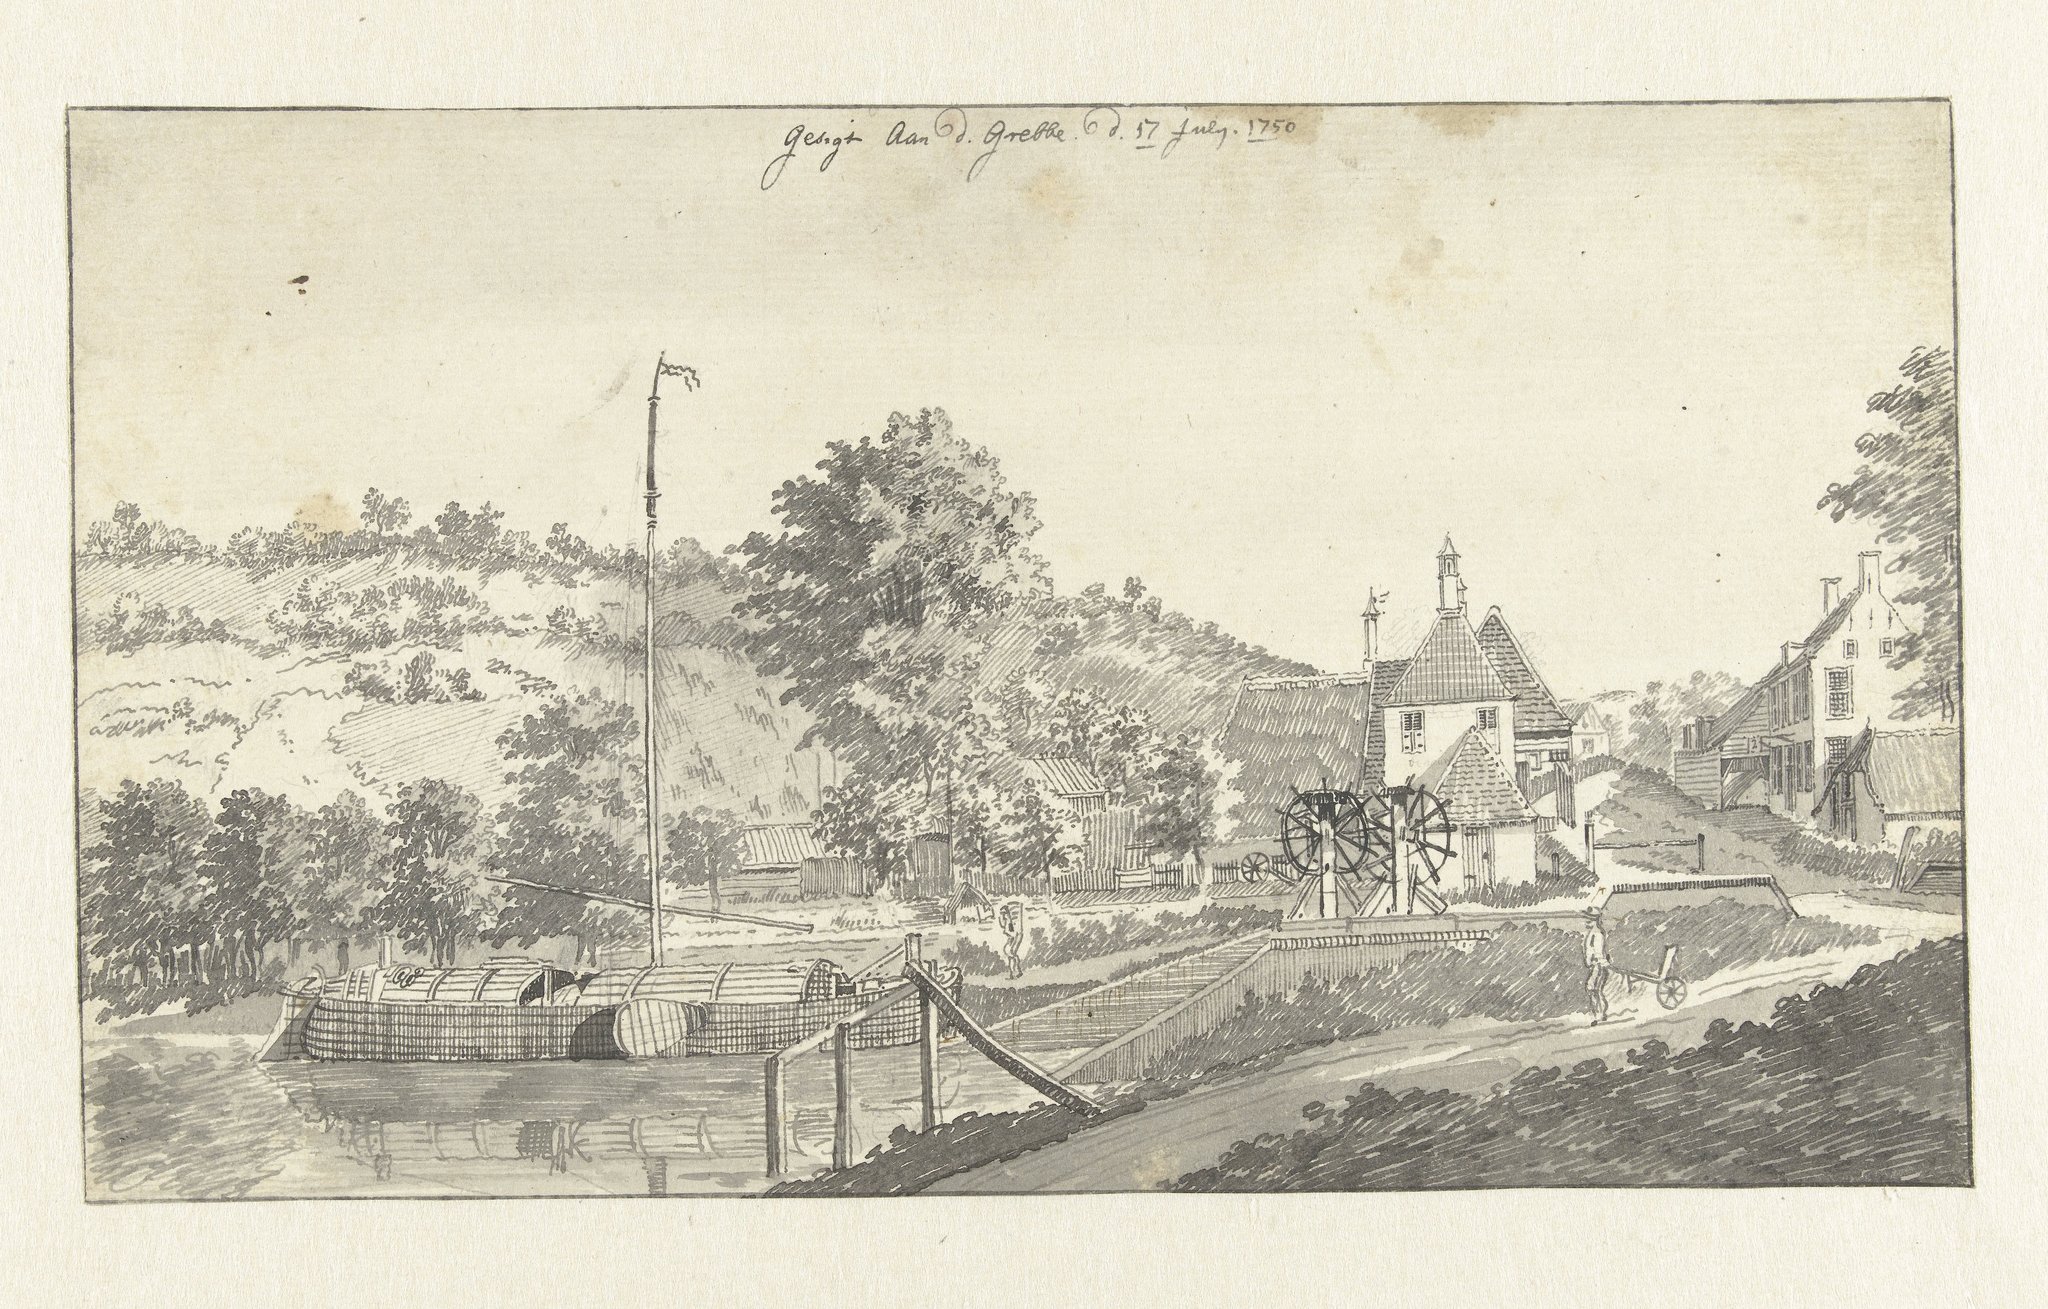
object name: drawing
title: Grebbesluis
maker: jan de beijer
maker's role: draughtsman, print maker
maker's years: 1703-1780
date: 1750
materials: ink, paper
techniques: brush, pen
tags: sluice, weir, prospect of city, town panorama, silhouette of city